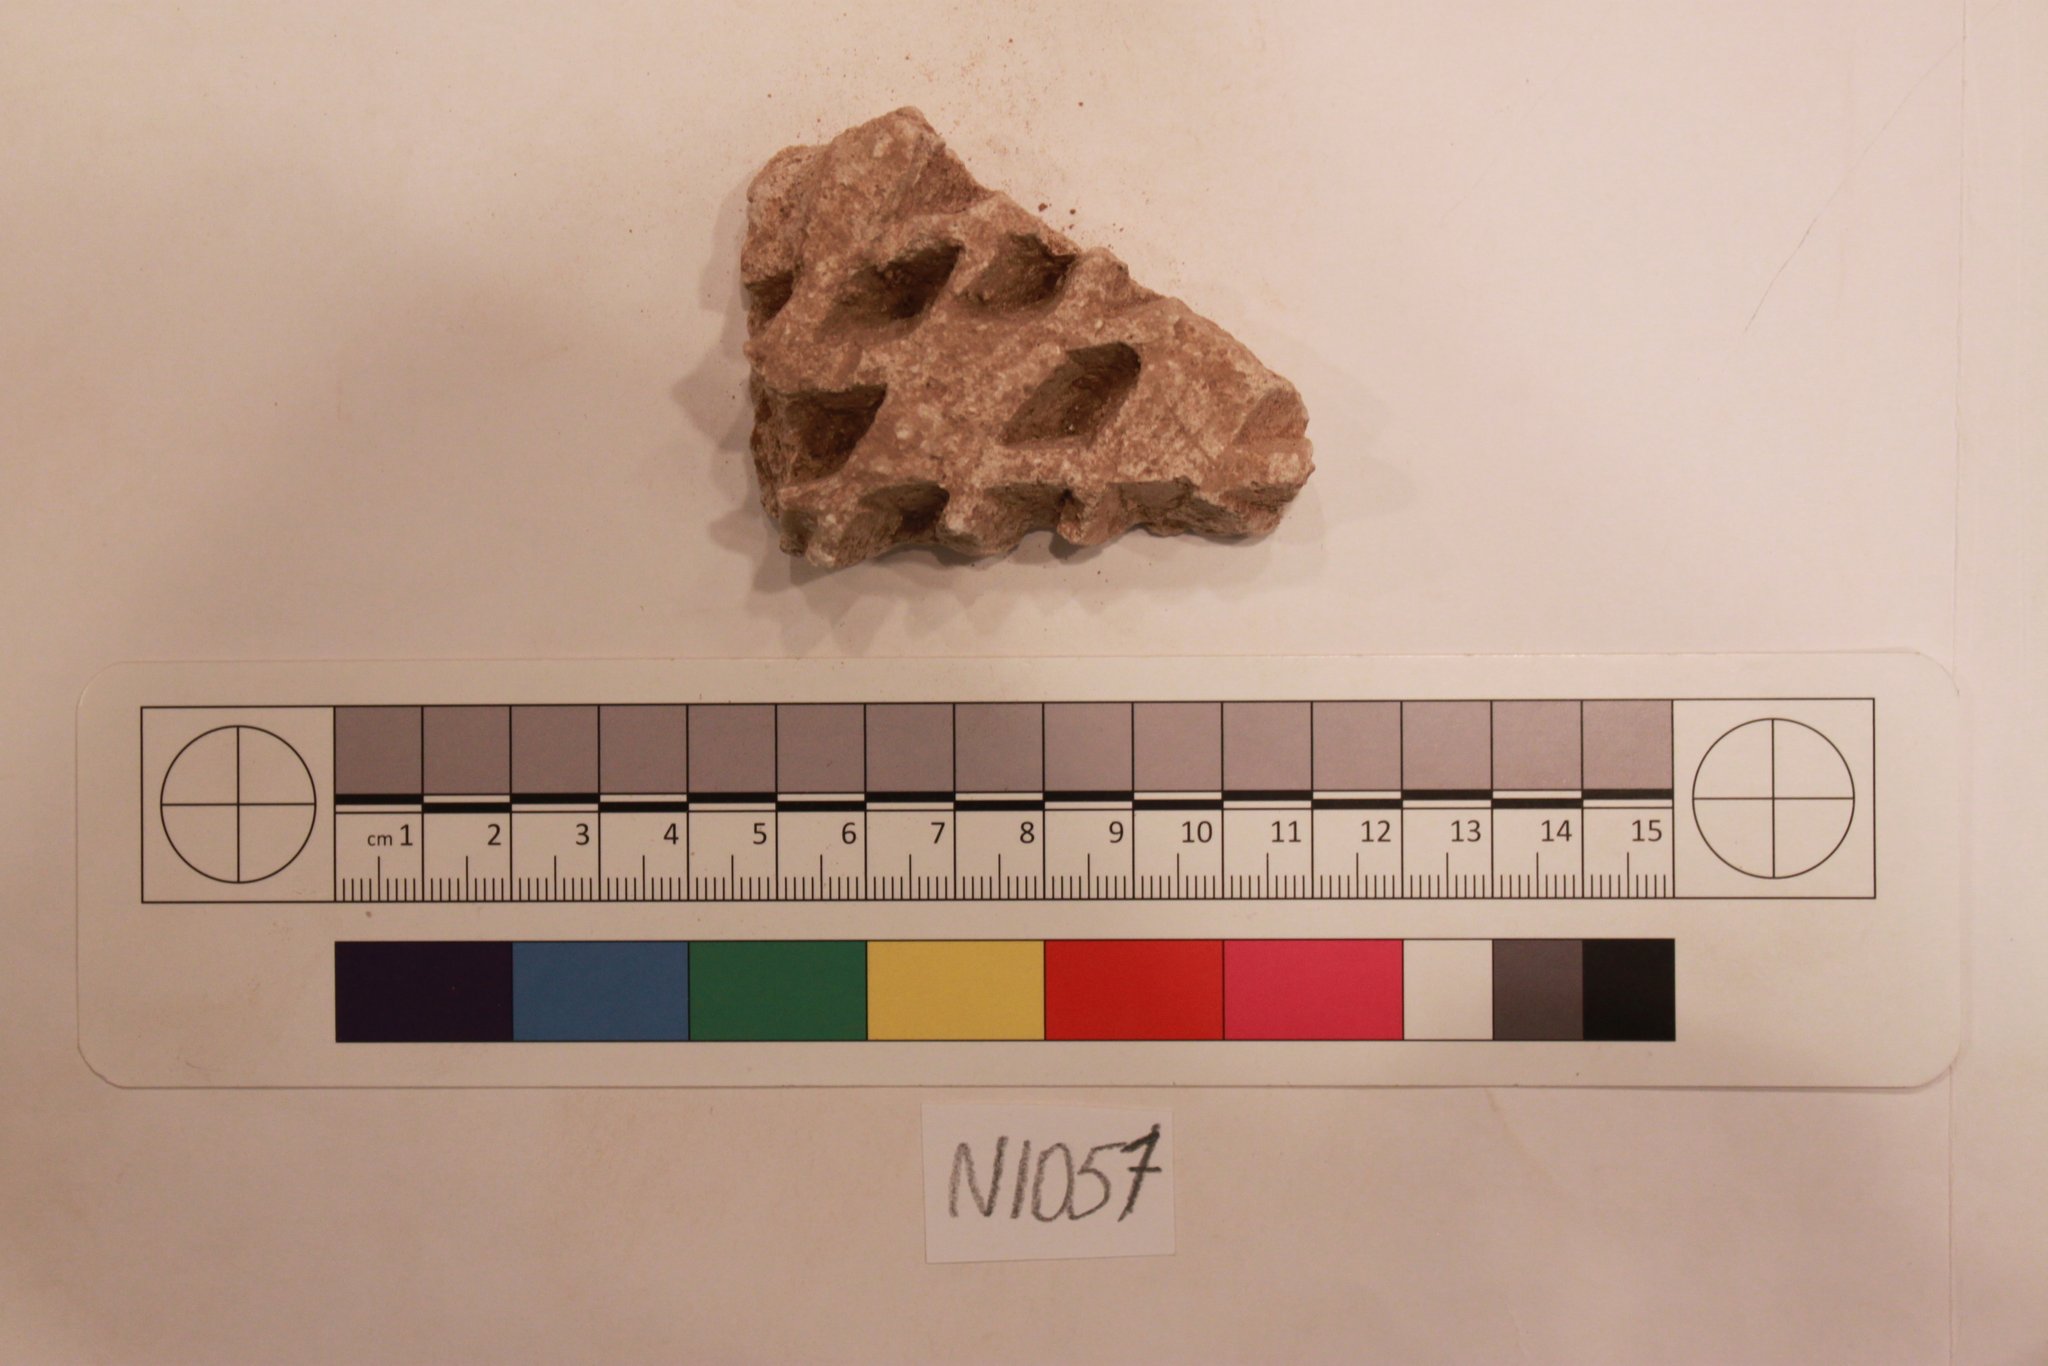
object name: fragment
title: Stucco Fragment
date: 701-1200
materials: plaster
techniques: carving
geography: iran